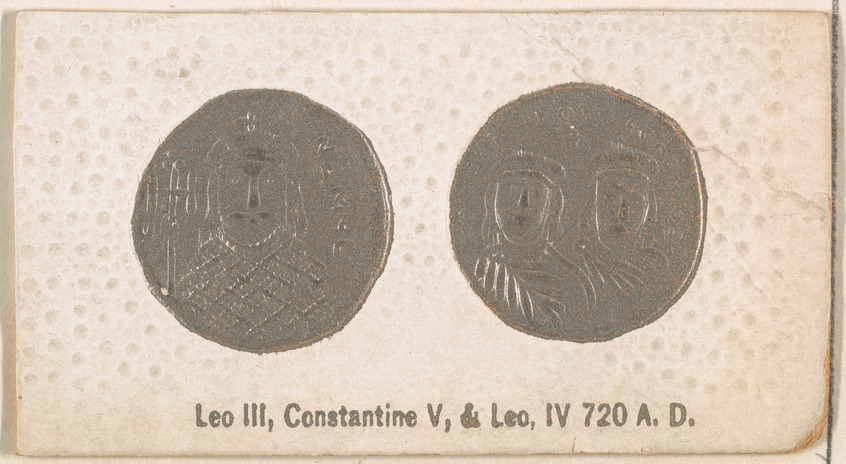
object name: print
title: Leo III, Constantine V, and Leo IV, 720 A.D., from the Ancient Coins series (N180) issued by Wm. S. Kimball & Co.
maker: william s. kimball & company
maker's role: publisher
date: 1888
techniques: color lithograph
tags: coins